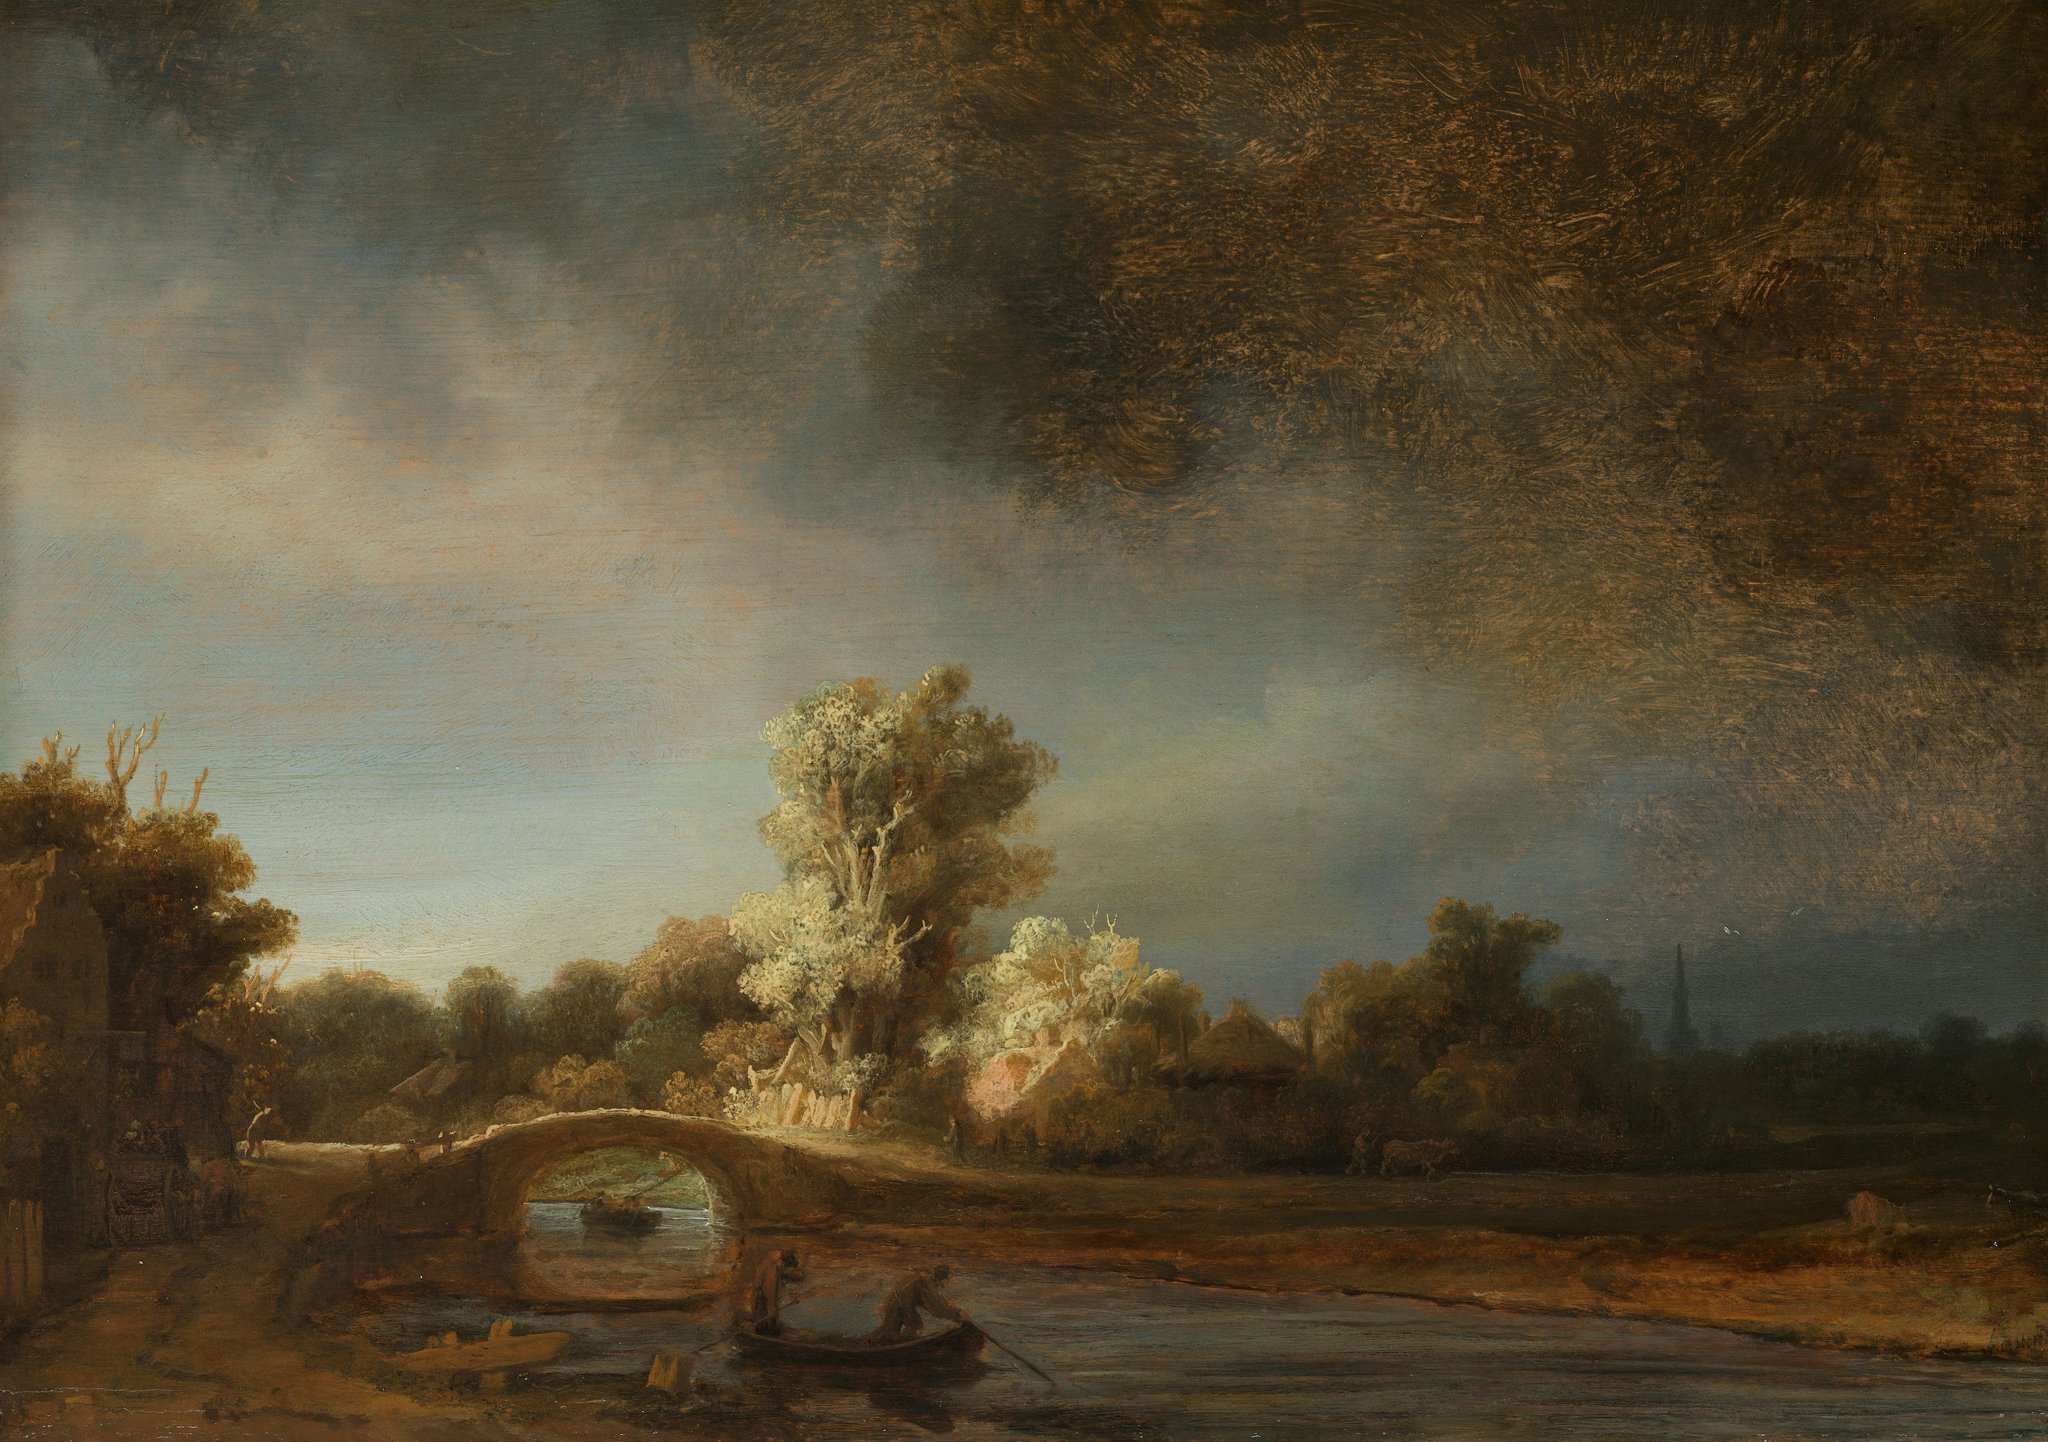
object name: painting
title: The Stone Bridge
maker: rembrandt van rijn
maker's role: draughtsman, painter, print maker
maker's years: 1606-1669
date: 1638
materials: oil, paint, panel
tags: landscape with bridge, viaduct or aqueduct, rowing-boat, canoe, etc.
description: Rembrandt painted only a few landscapes, mostly imaginary mountain scenes. Although The Stone Bridge is composed of elements studied from reality, it probably does not represent a specific place. The painting’s magical quality derives from its dramatic illumination: a beam of sunlight breaks through the clouds, making the approaching storm seem twice as menacing.